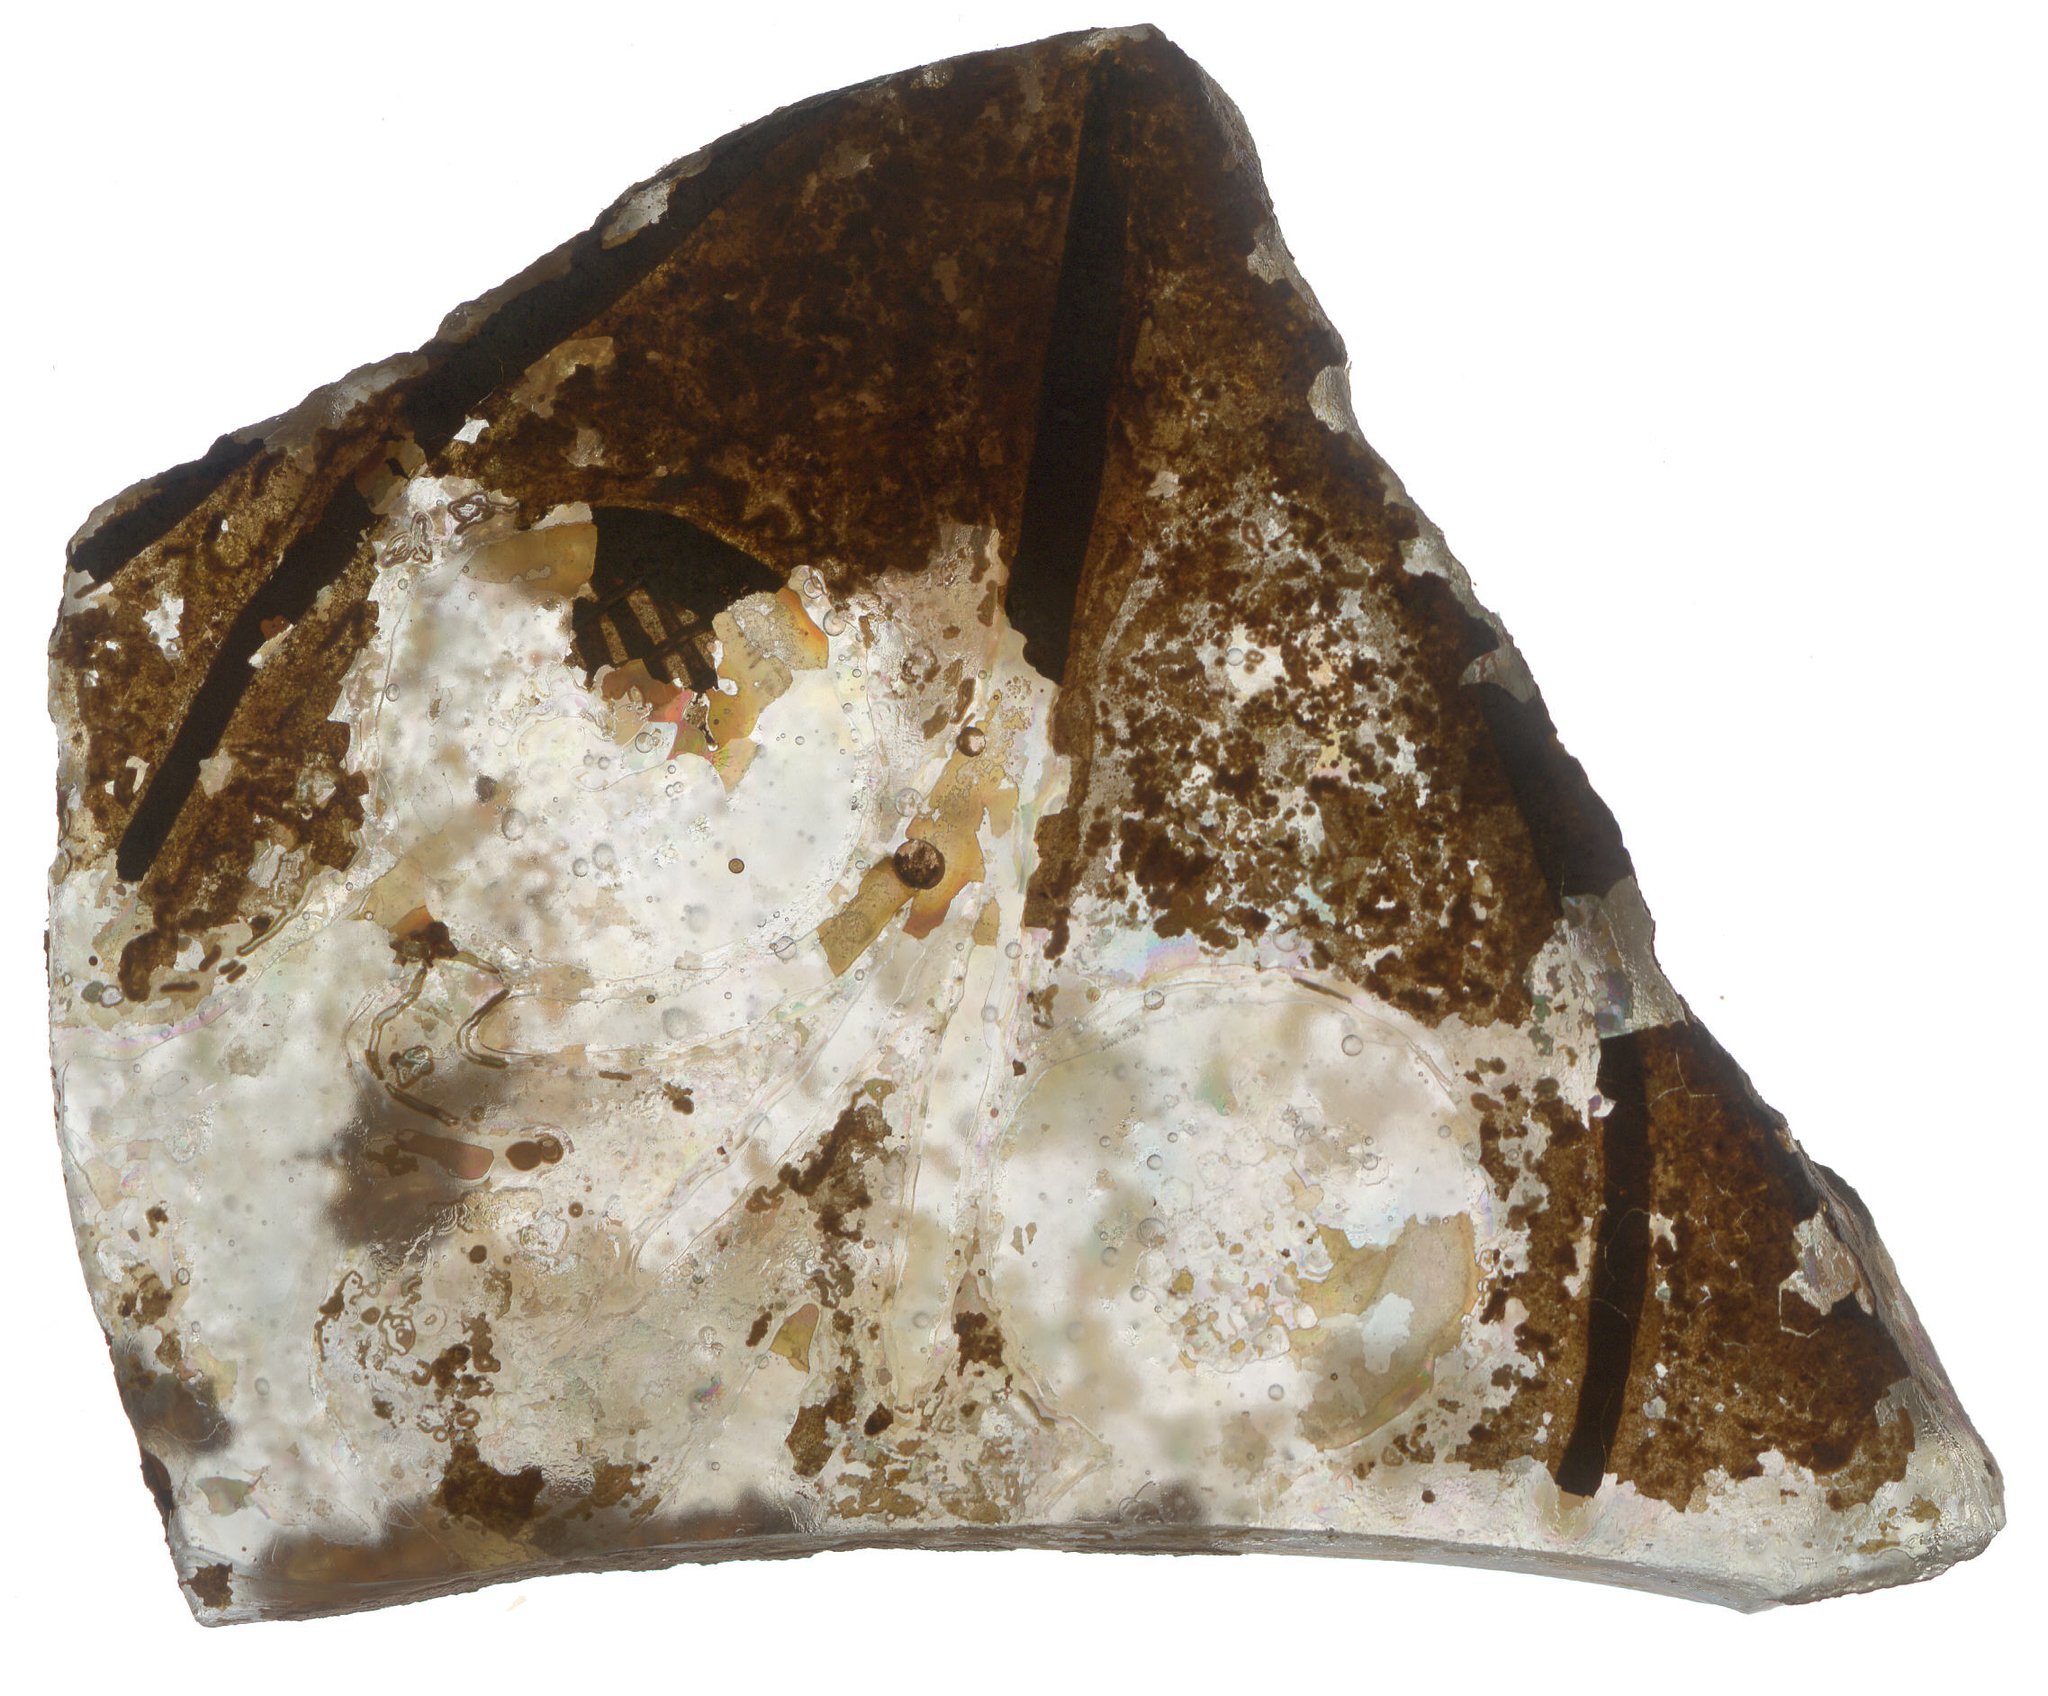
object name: fragment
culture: crusader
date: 1201-1300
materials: glass